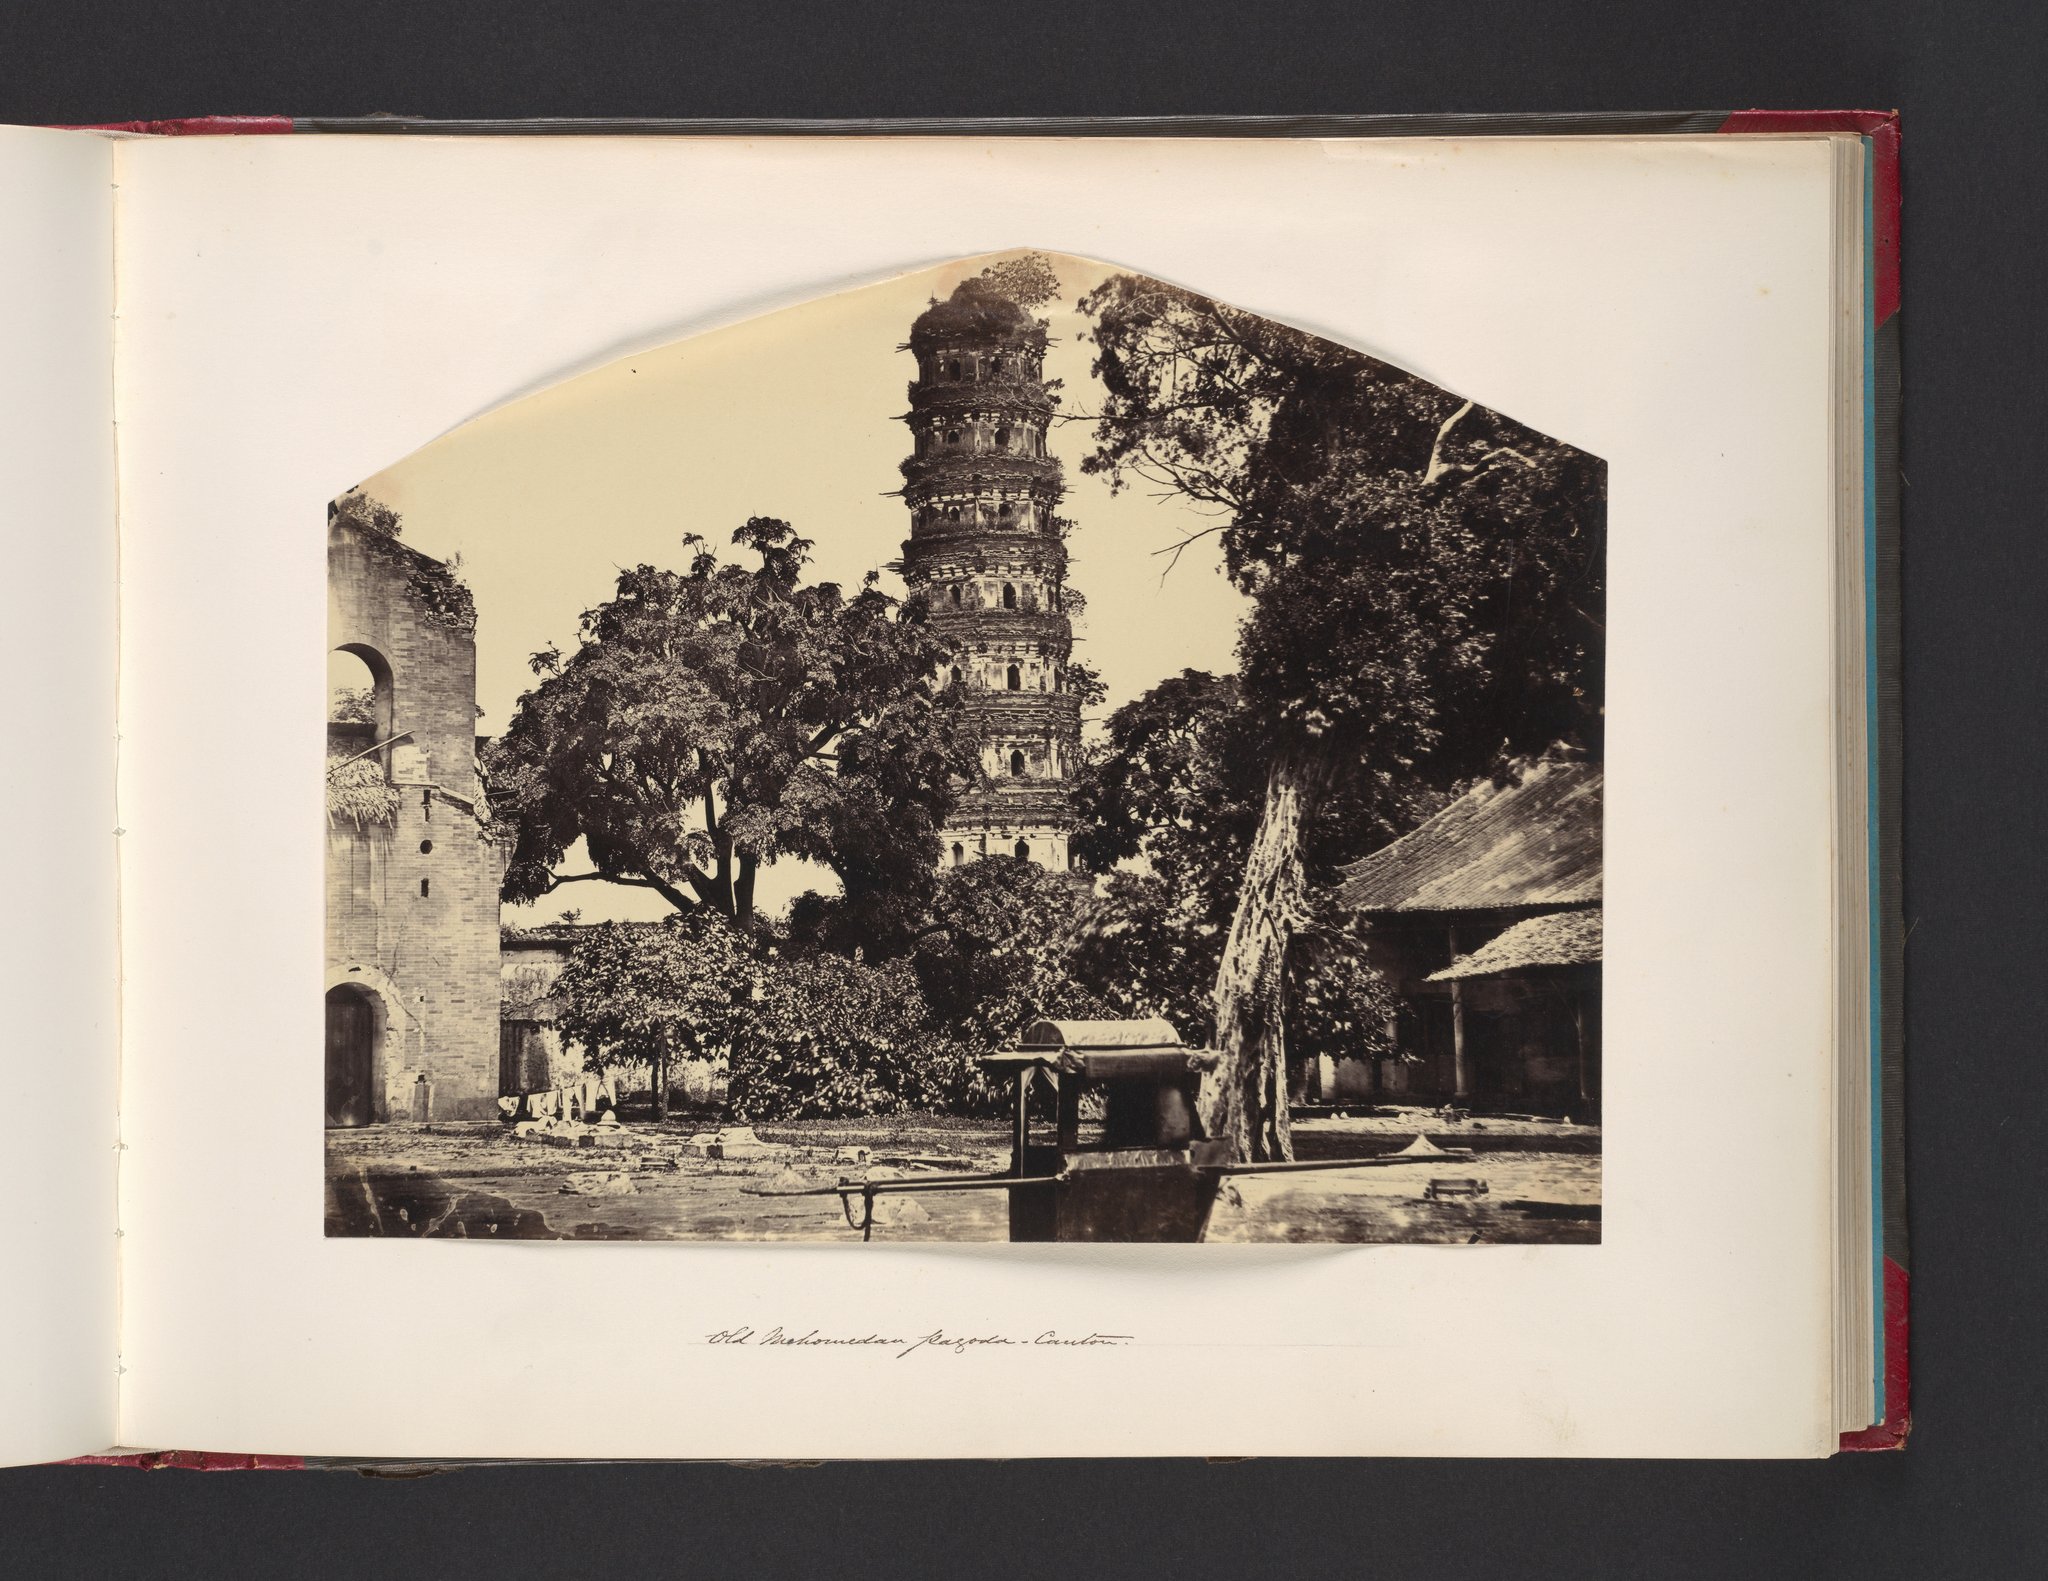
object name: photograph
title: Old Mahomedan Pagoda. Canton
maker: john thomson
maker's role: artist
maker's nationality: british, scottish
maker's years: 1837-1921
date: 1865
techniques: albumen silver print, glass negative